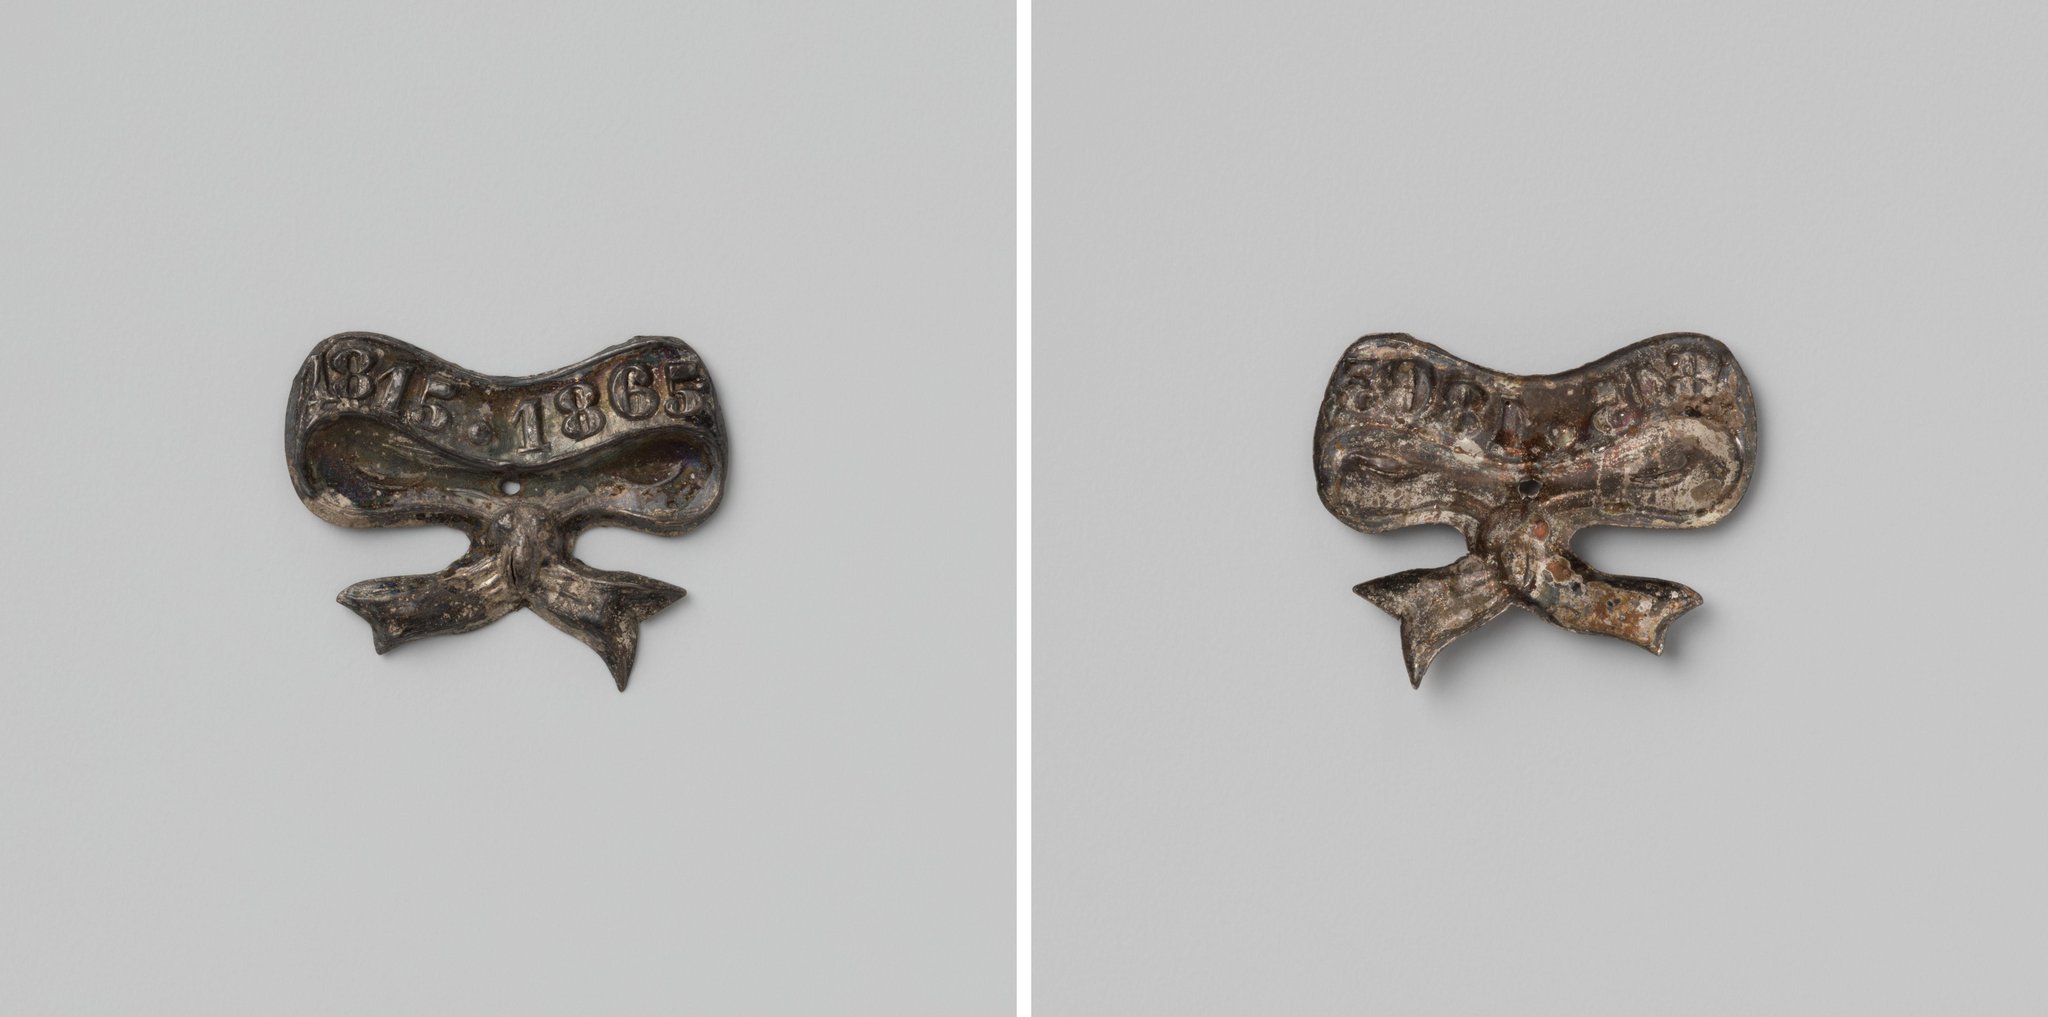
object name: insignia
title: Vijftigjarige viering van slag bij Waterloo, draagteken ter ere van Willem II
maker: Anonymous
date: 1865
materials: silver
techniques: striking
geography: netherlands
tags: the hague, william ii of the netherlands, waterloo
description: Eenzijdig zilveren draagteken, bestaande uit gestrikt lint met opschrift